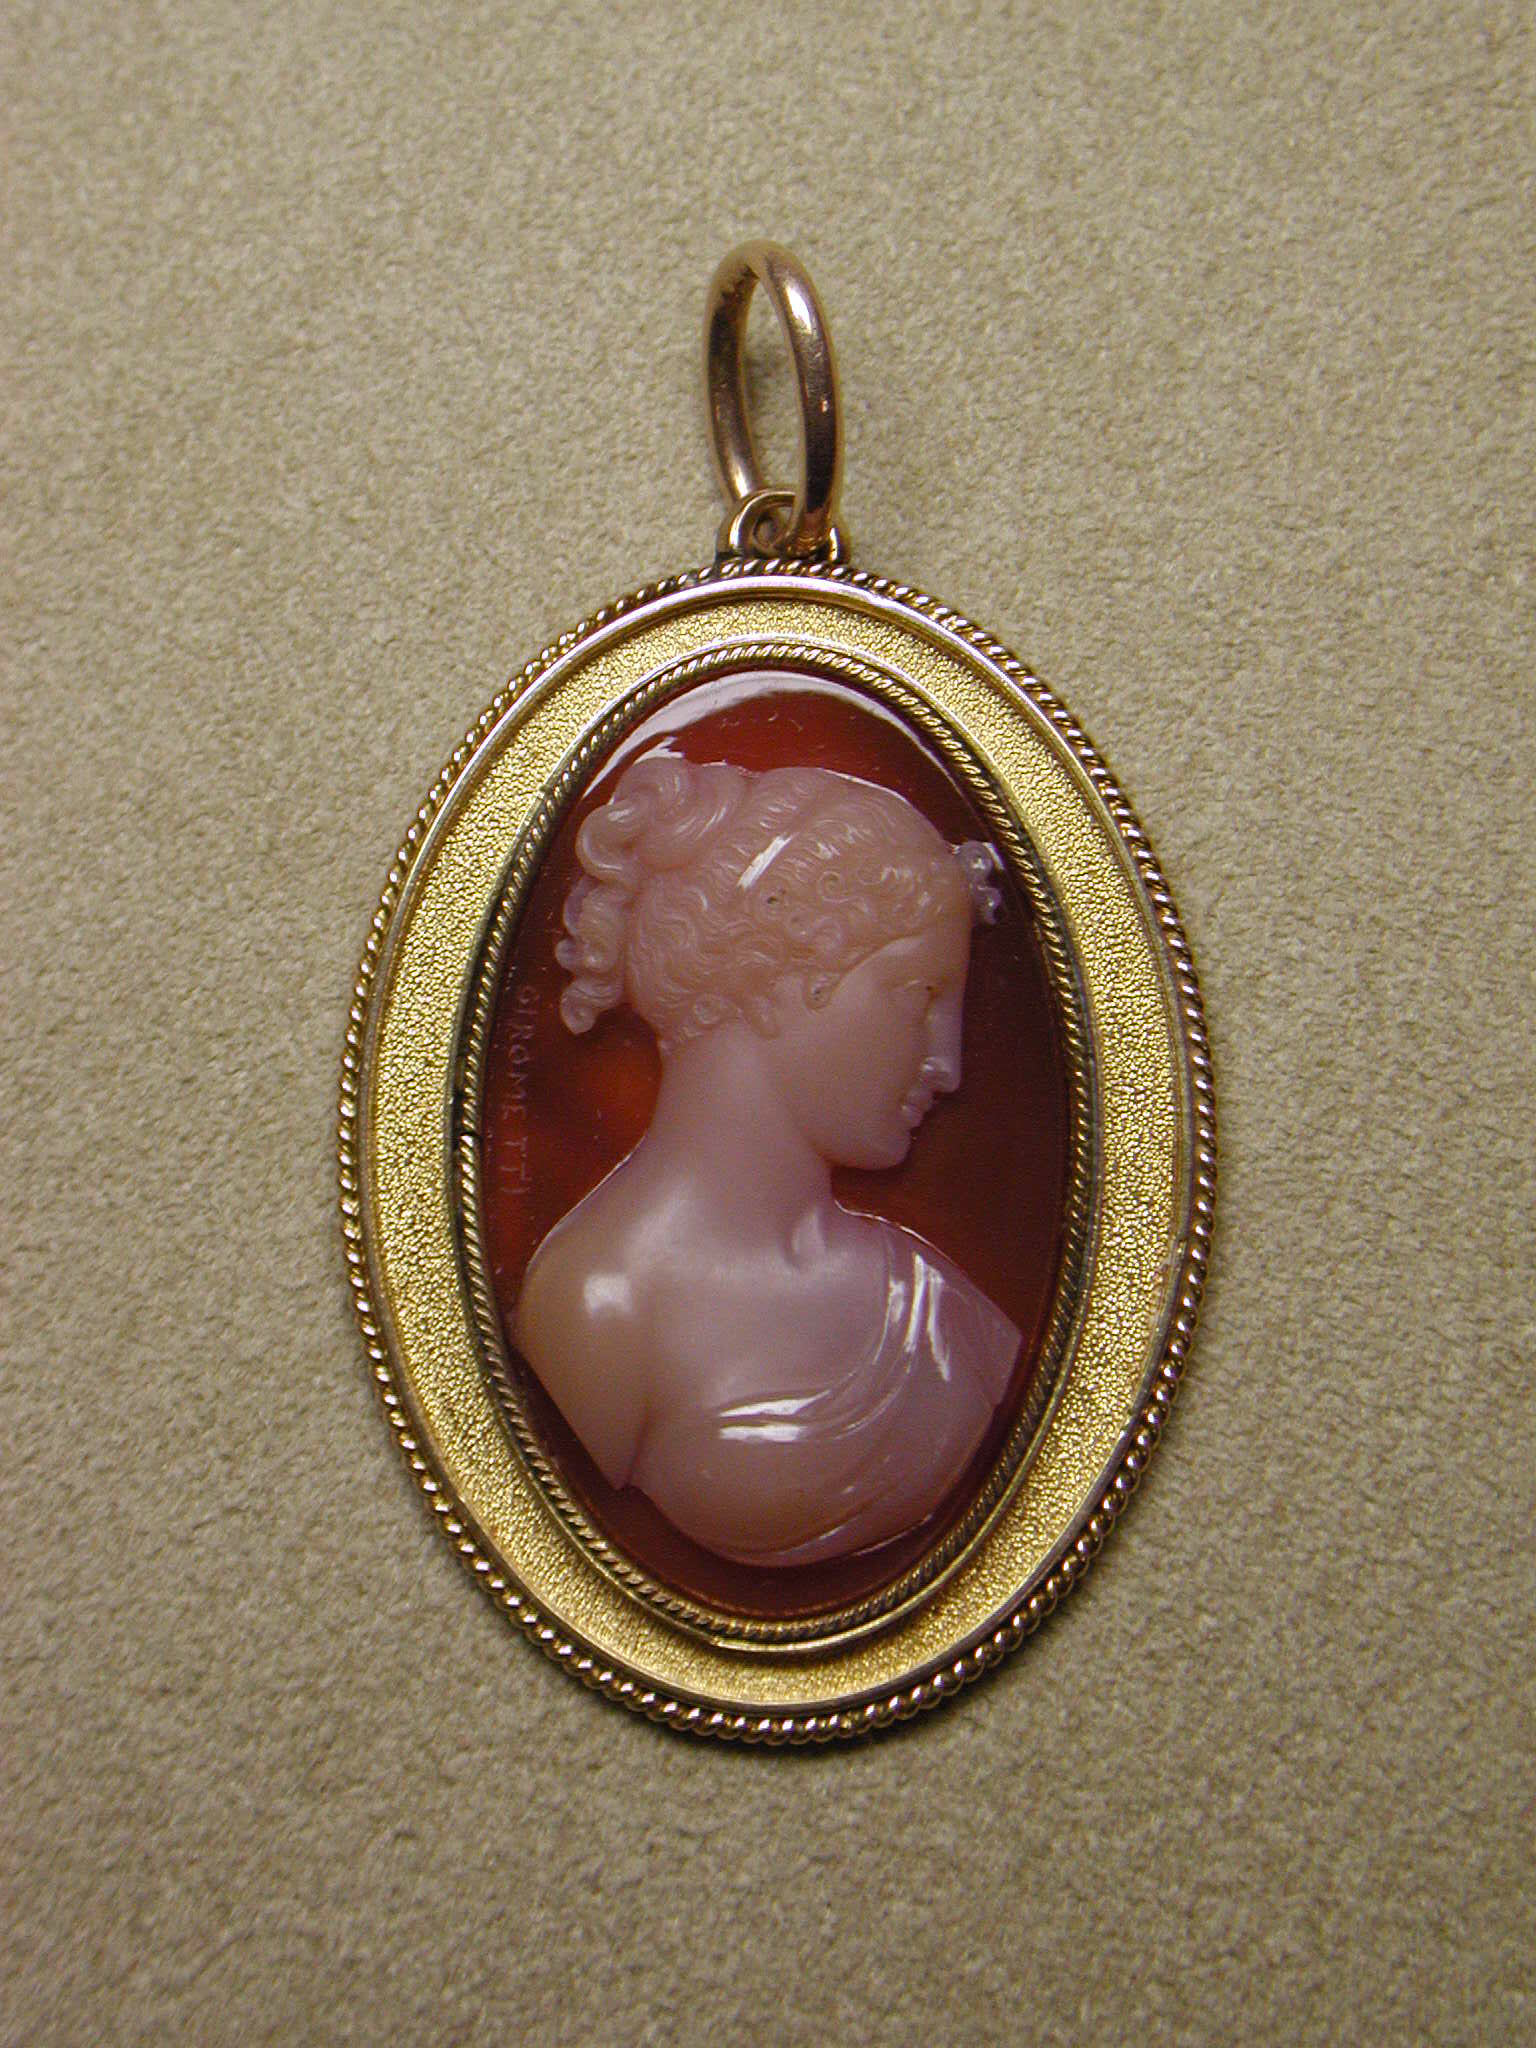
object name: cameo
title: Bust of a young woman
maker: giuseppe girometti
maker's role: artist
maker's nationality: italian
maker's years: 1780-1851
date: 1801-1833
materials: gold, gemstone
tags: profiles,women